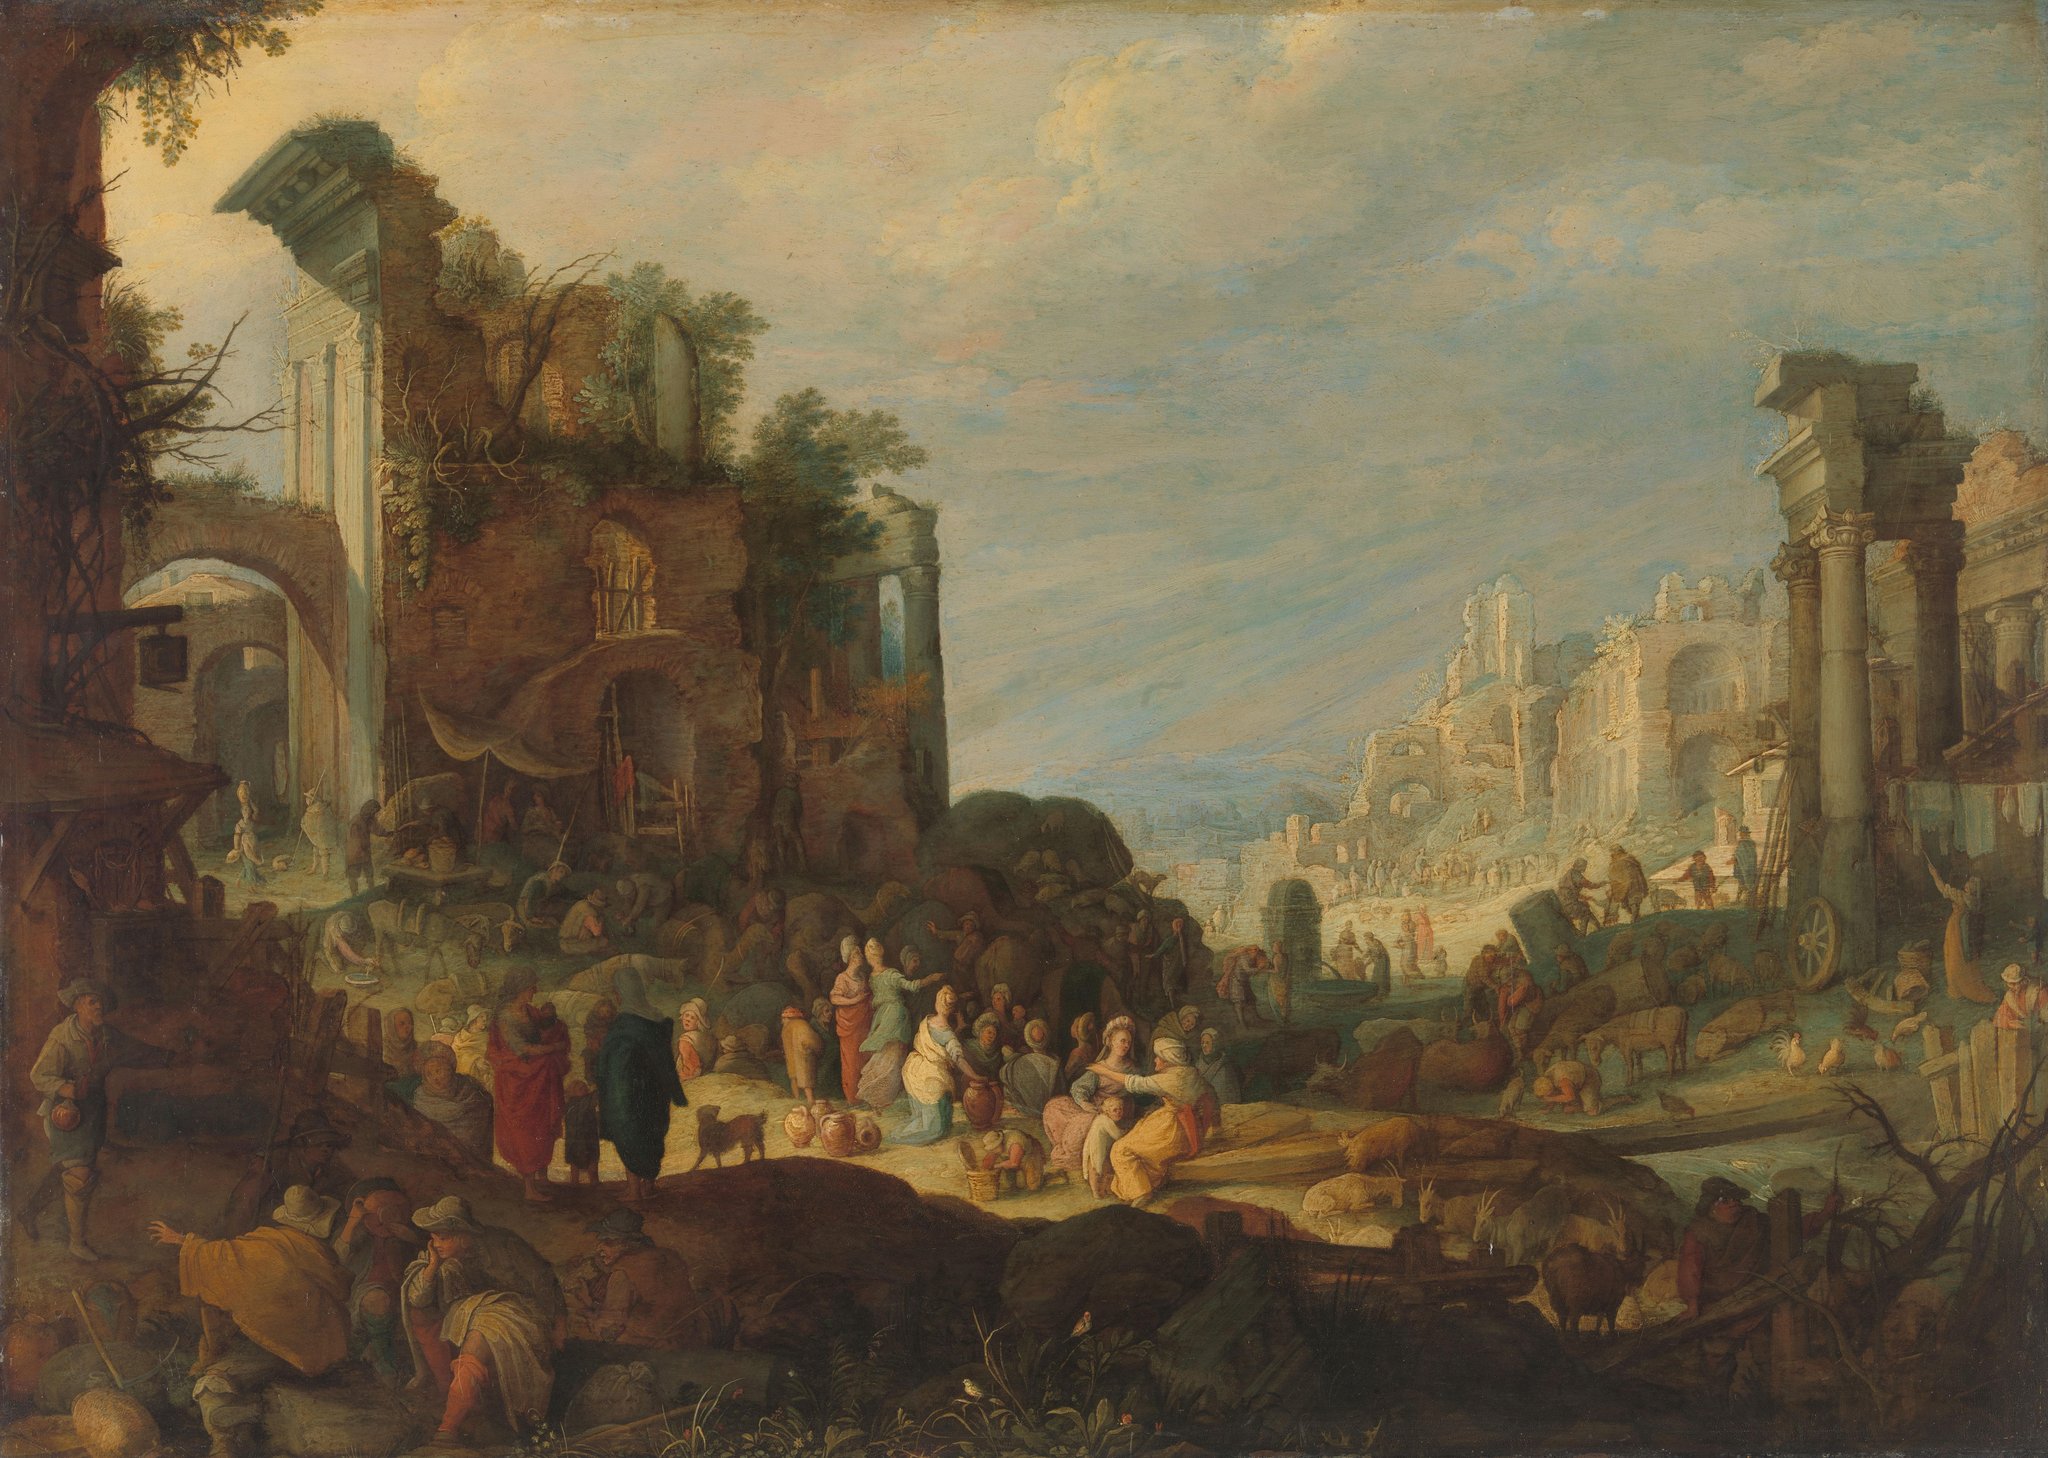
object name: painting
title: Travellers among Roman Ruins with Rebecca and Eliezer at the Well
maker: guilliam van nieulandt (ii)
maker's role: draughtsman, print maker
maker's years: 1584-1635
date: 1602-1605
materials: copper, oil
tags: landscape with ruins, the meeting at the well: eliezer sees rebekah coming with a pitcher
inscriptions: inscription, bottom right: ‘P briL’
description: Willem van Nieulandt (1584 - 1636). Landscape with Roman ruins, c. 1605. In this landscape with ancient ruins we see a number of figures. The group of camels on the left suggests that they are biblical characters. Those near the fountain may represent the Old Testament figure of Rebecca, with Abraham's servant. The ruins in the painting are authentic - they stood in the Forum Romanum in Rome - but here the painter has arbitrarily located them in the midst of an imaginary landscape. Painted on copper. Purchased in 1809 (as the work of Paulus Bril), as part of the Van Heteren Gevers collection (The Hague).